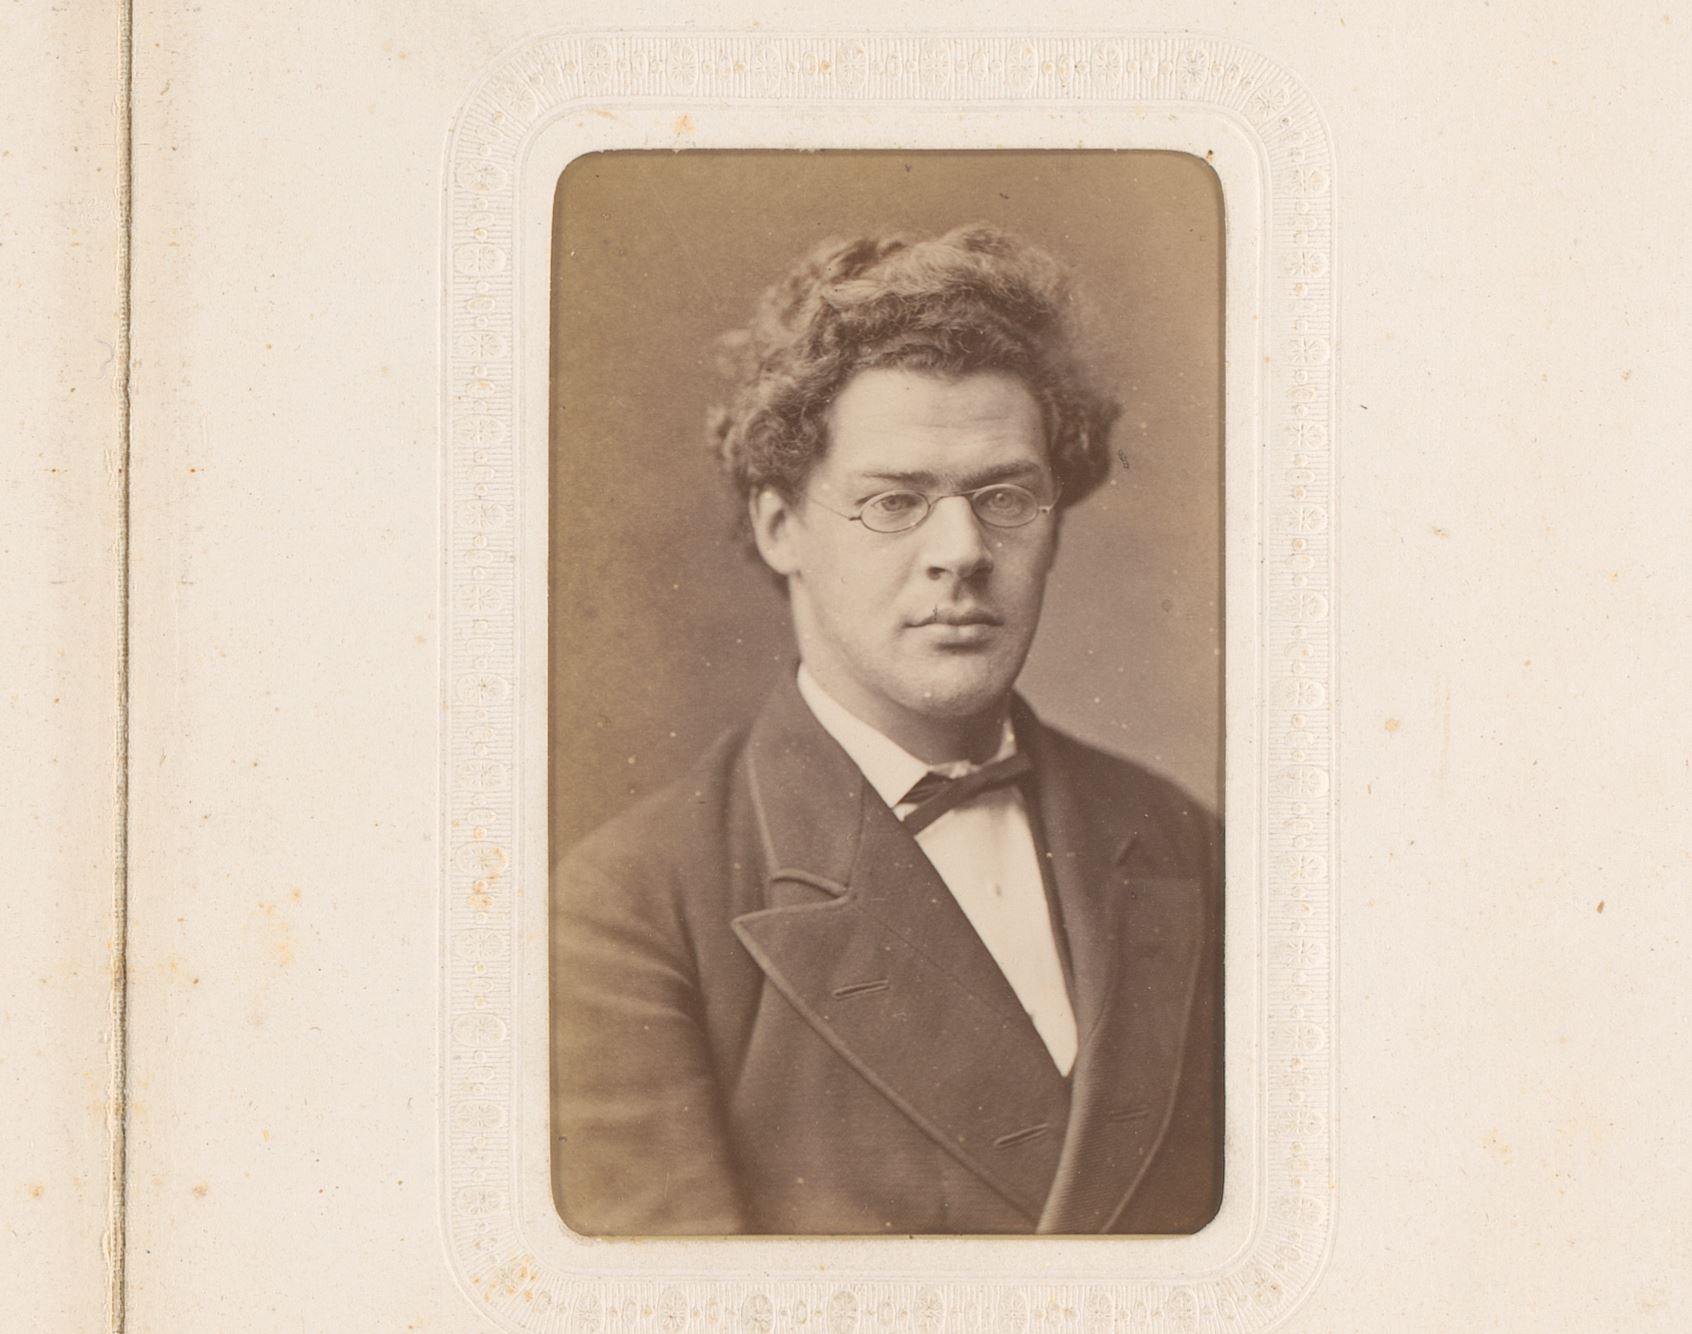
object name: carte de visite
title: Portret van een man met bril en vlinderstrik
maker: Anonymous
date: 1860-1900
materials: cardboard, photographic support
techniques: albumen print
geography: netherlands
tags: eyeglasses, spectacles, historical persons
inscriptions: name: ‘C. Bru[yn]’